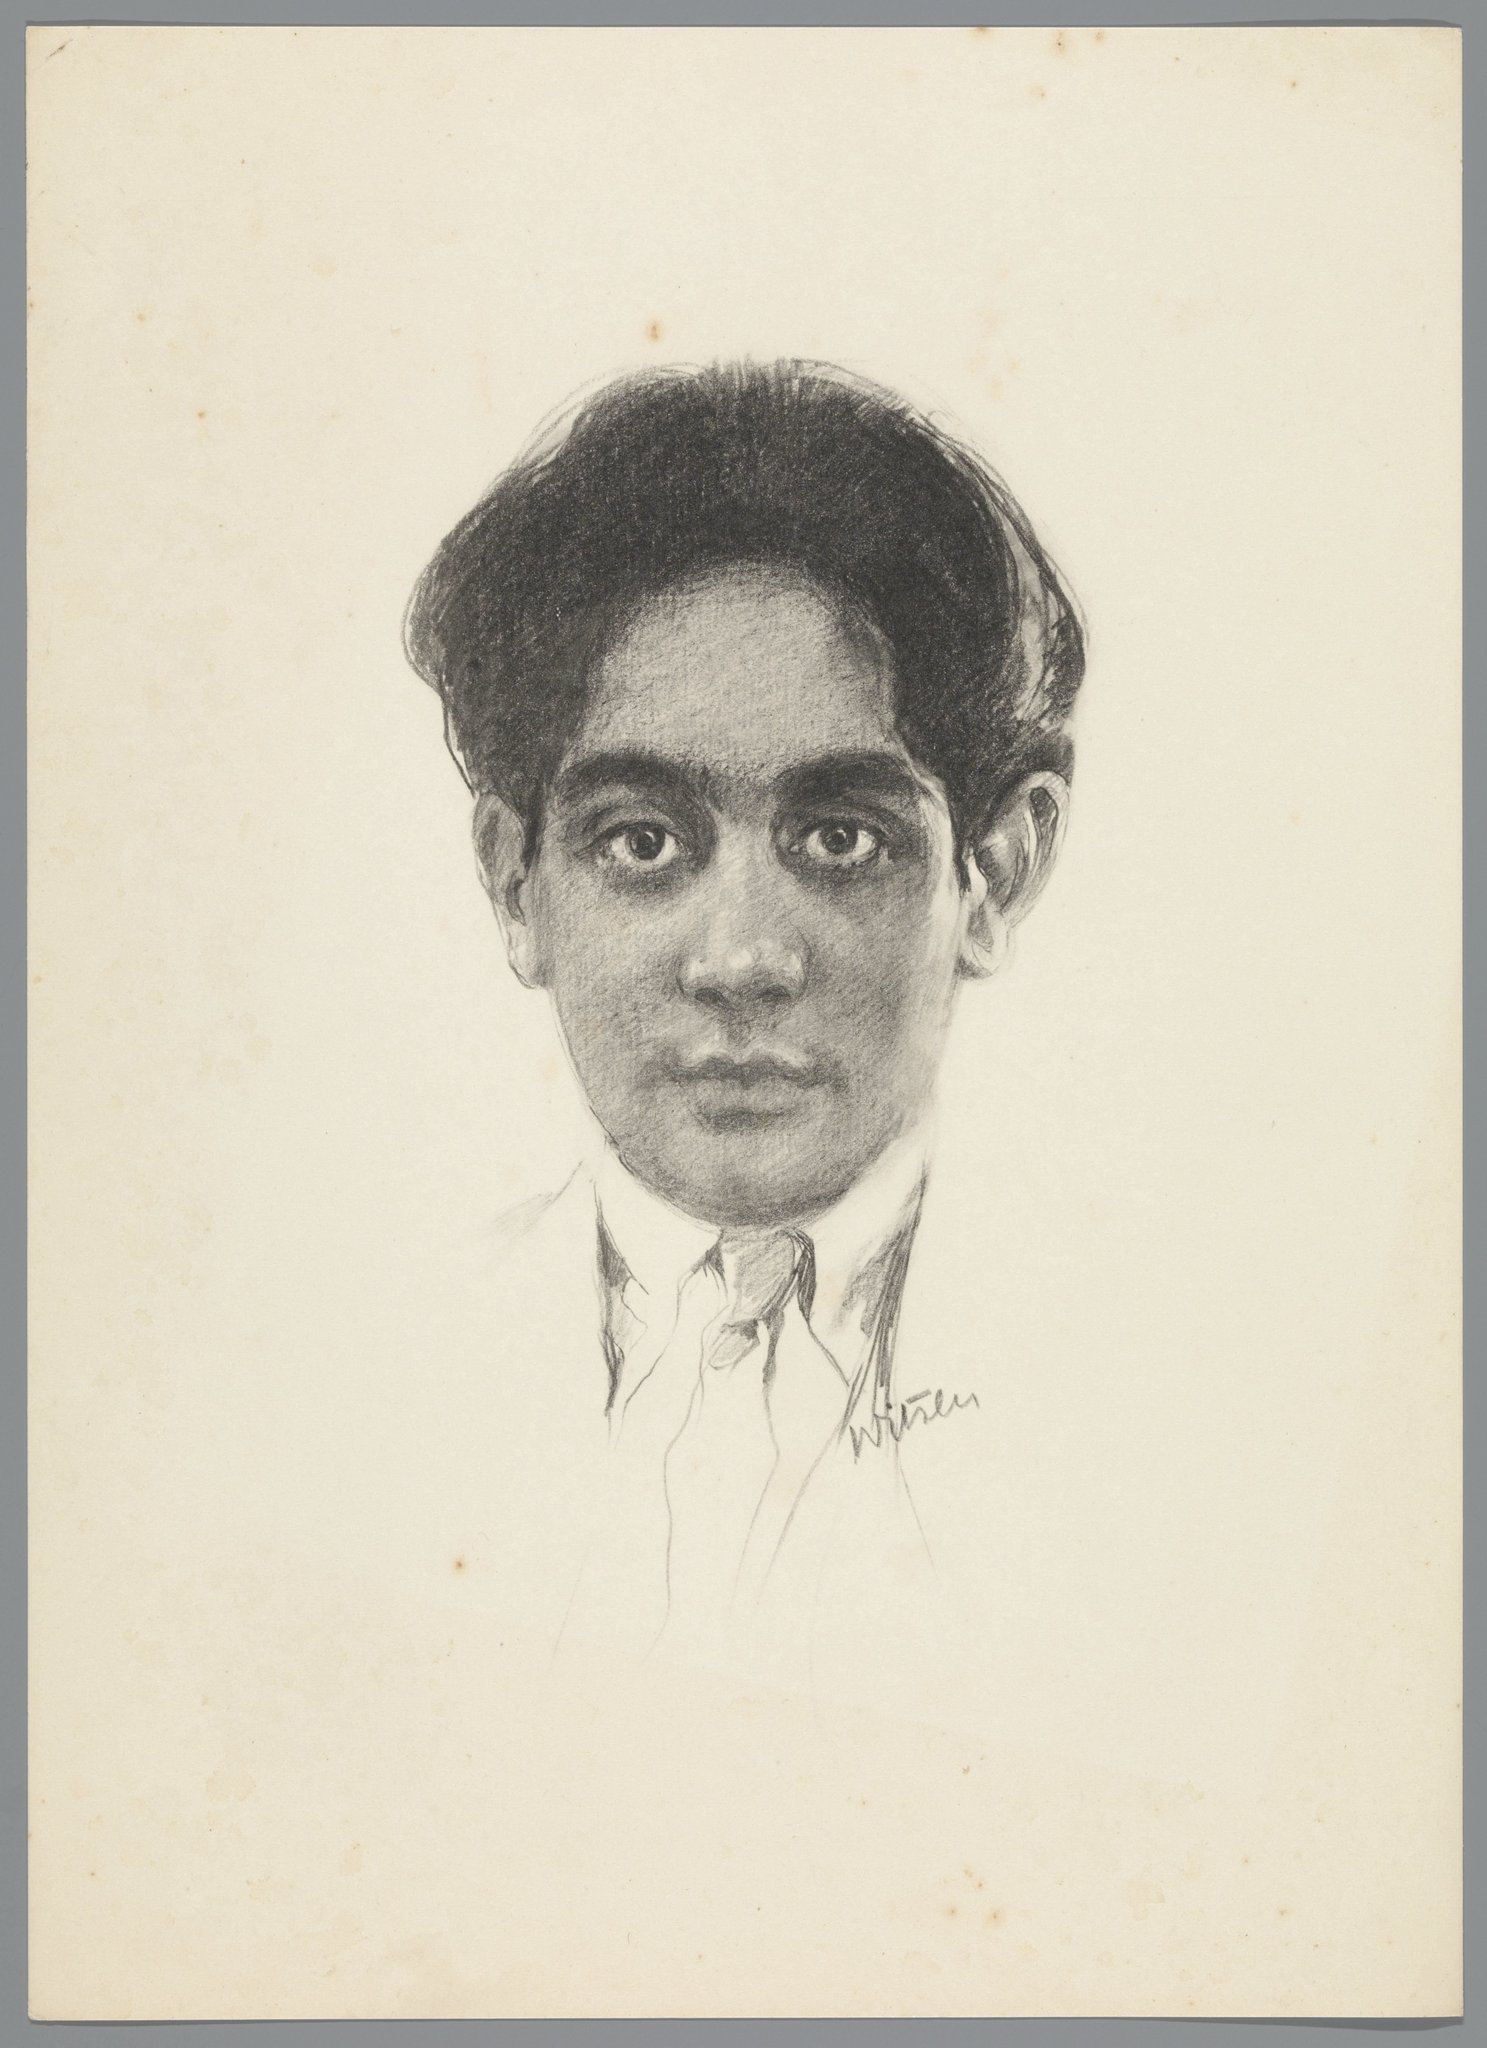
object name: reproduction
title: Reproductie van tekening met portret van Karamjit Singh Sahib Bahadur, prins van Kapurthala, door Willem Witsen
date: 1915-1916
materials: paper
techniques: photograph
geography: netherlands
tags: politician, historical persons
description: Voor schilderij van de geportretteerde door Witsen, zie collectie Dordrechts Museum (bruikleen RCE).